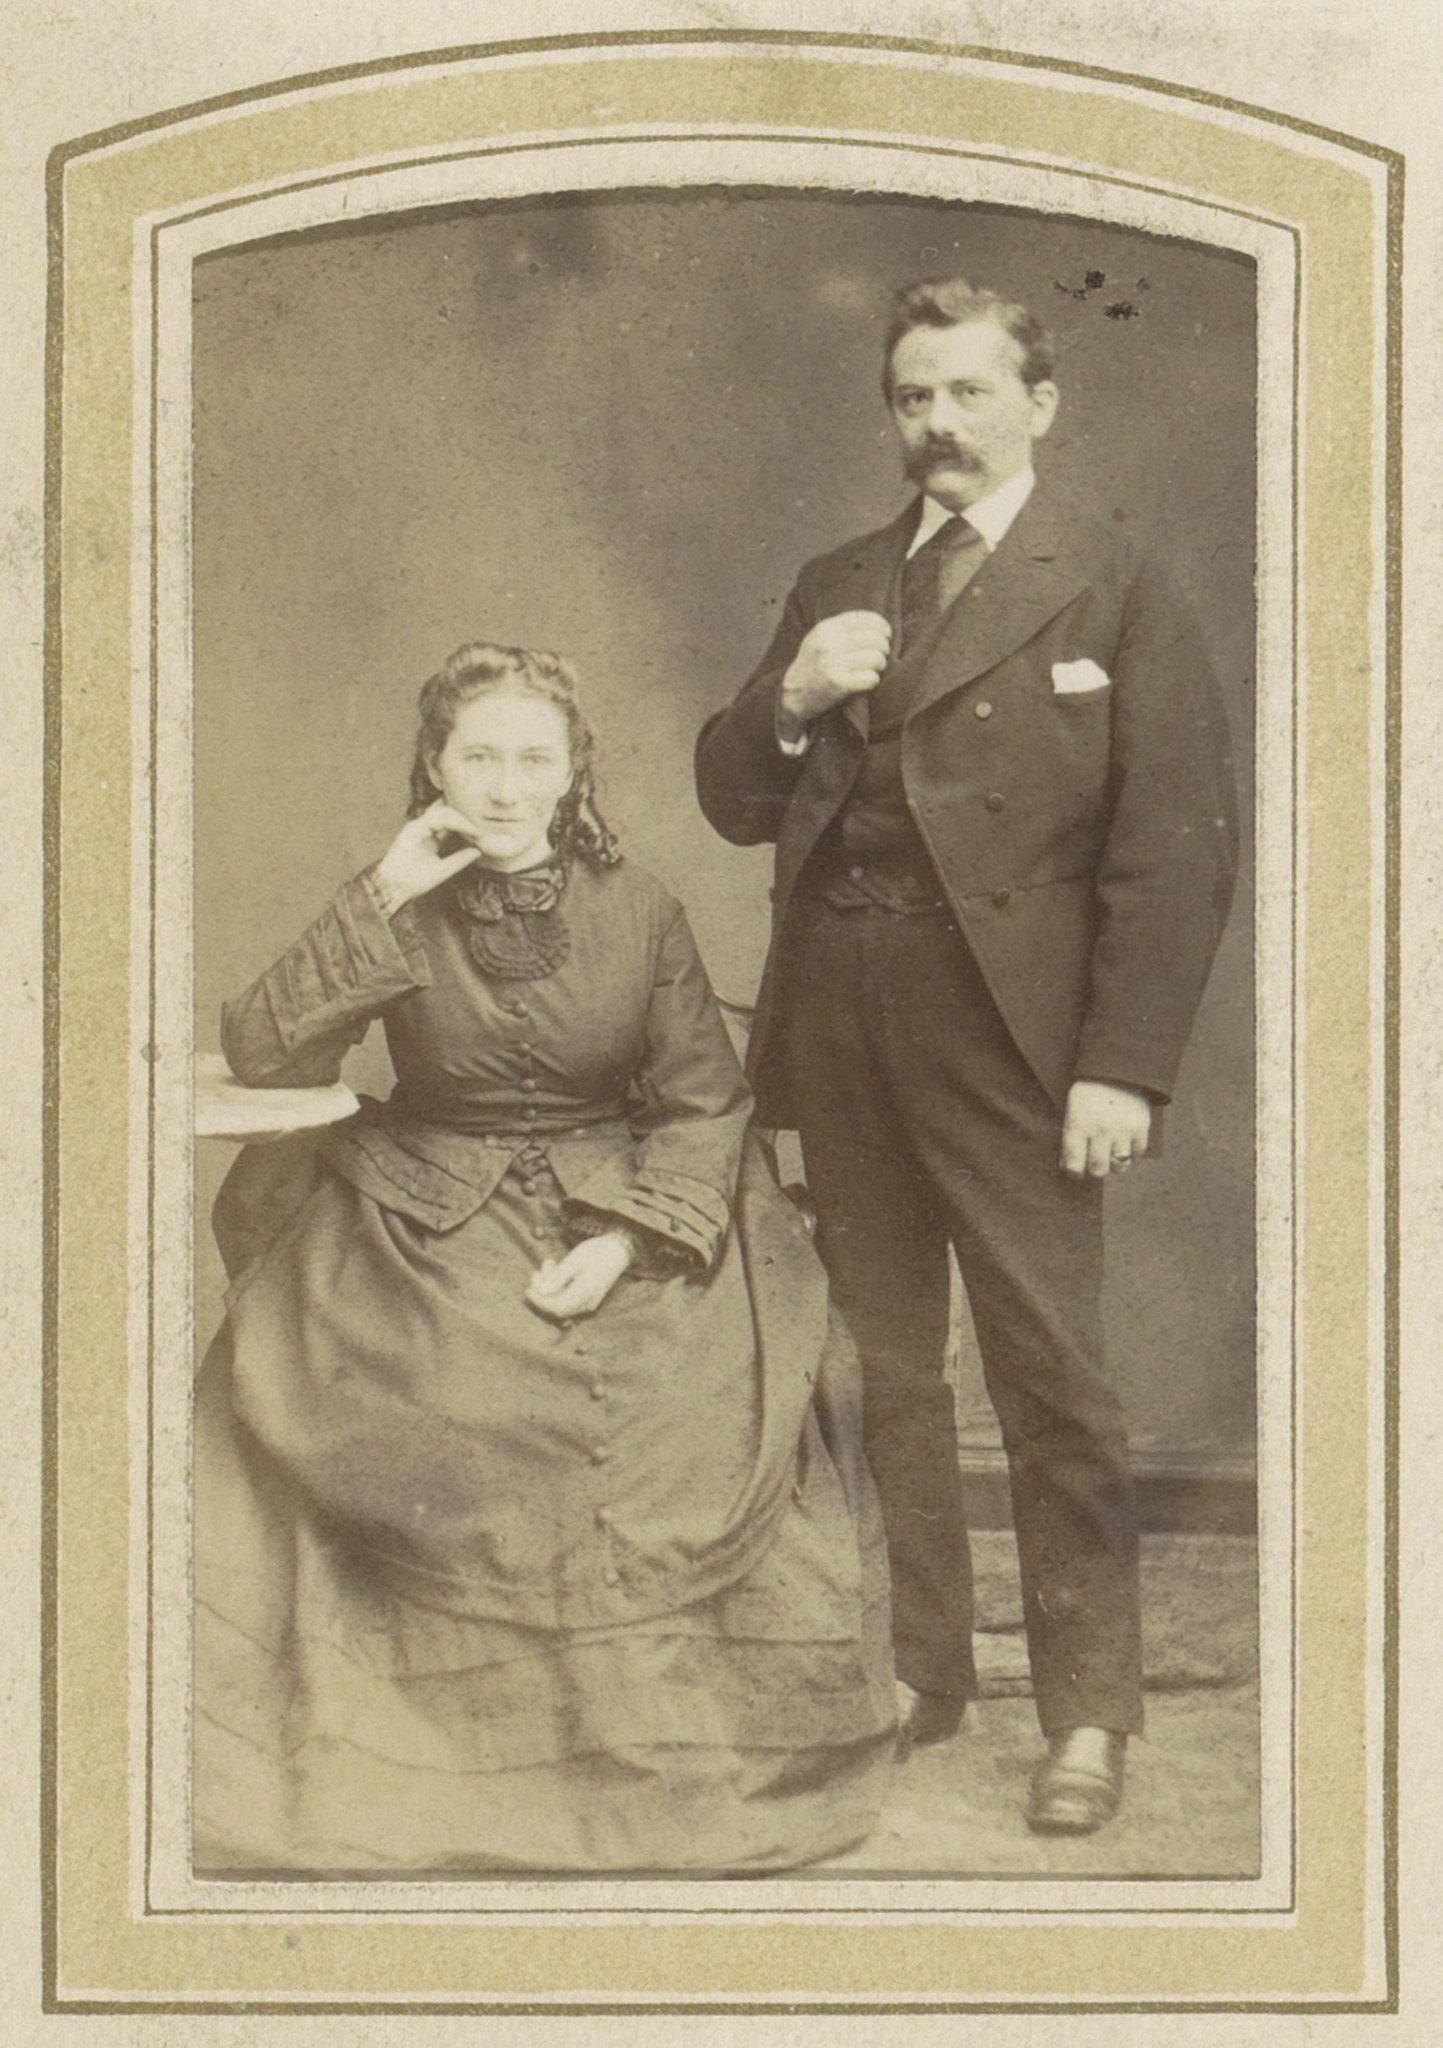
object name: carte de visite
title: Portret van een man en een vrouw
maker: Anonymous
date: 1860-1900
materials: cardboard, paper, photographic support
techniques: albumen print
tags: studio requisites ~ photographer, clothing for the lower part of the body, moustache, historical persons, styles of hairdress - aa - ~ women, clothing for the upper part of the body, dress, gown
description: Onderdeel van Fotoalbum van een Nederlandse familie met 168 cartes-de-visite en kabinetfoto's.